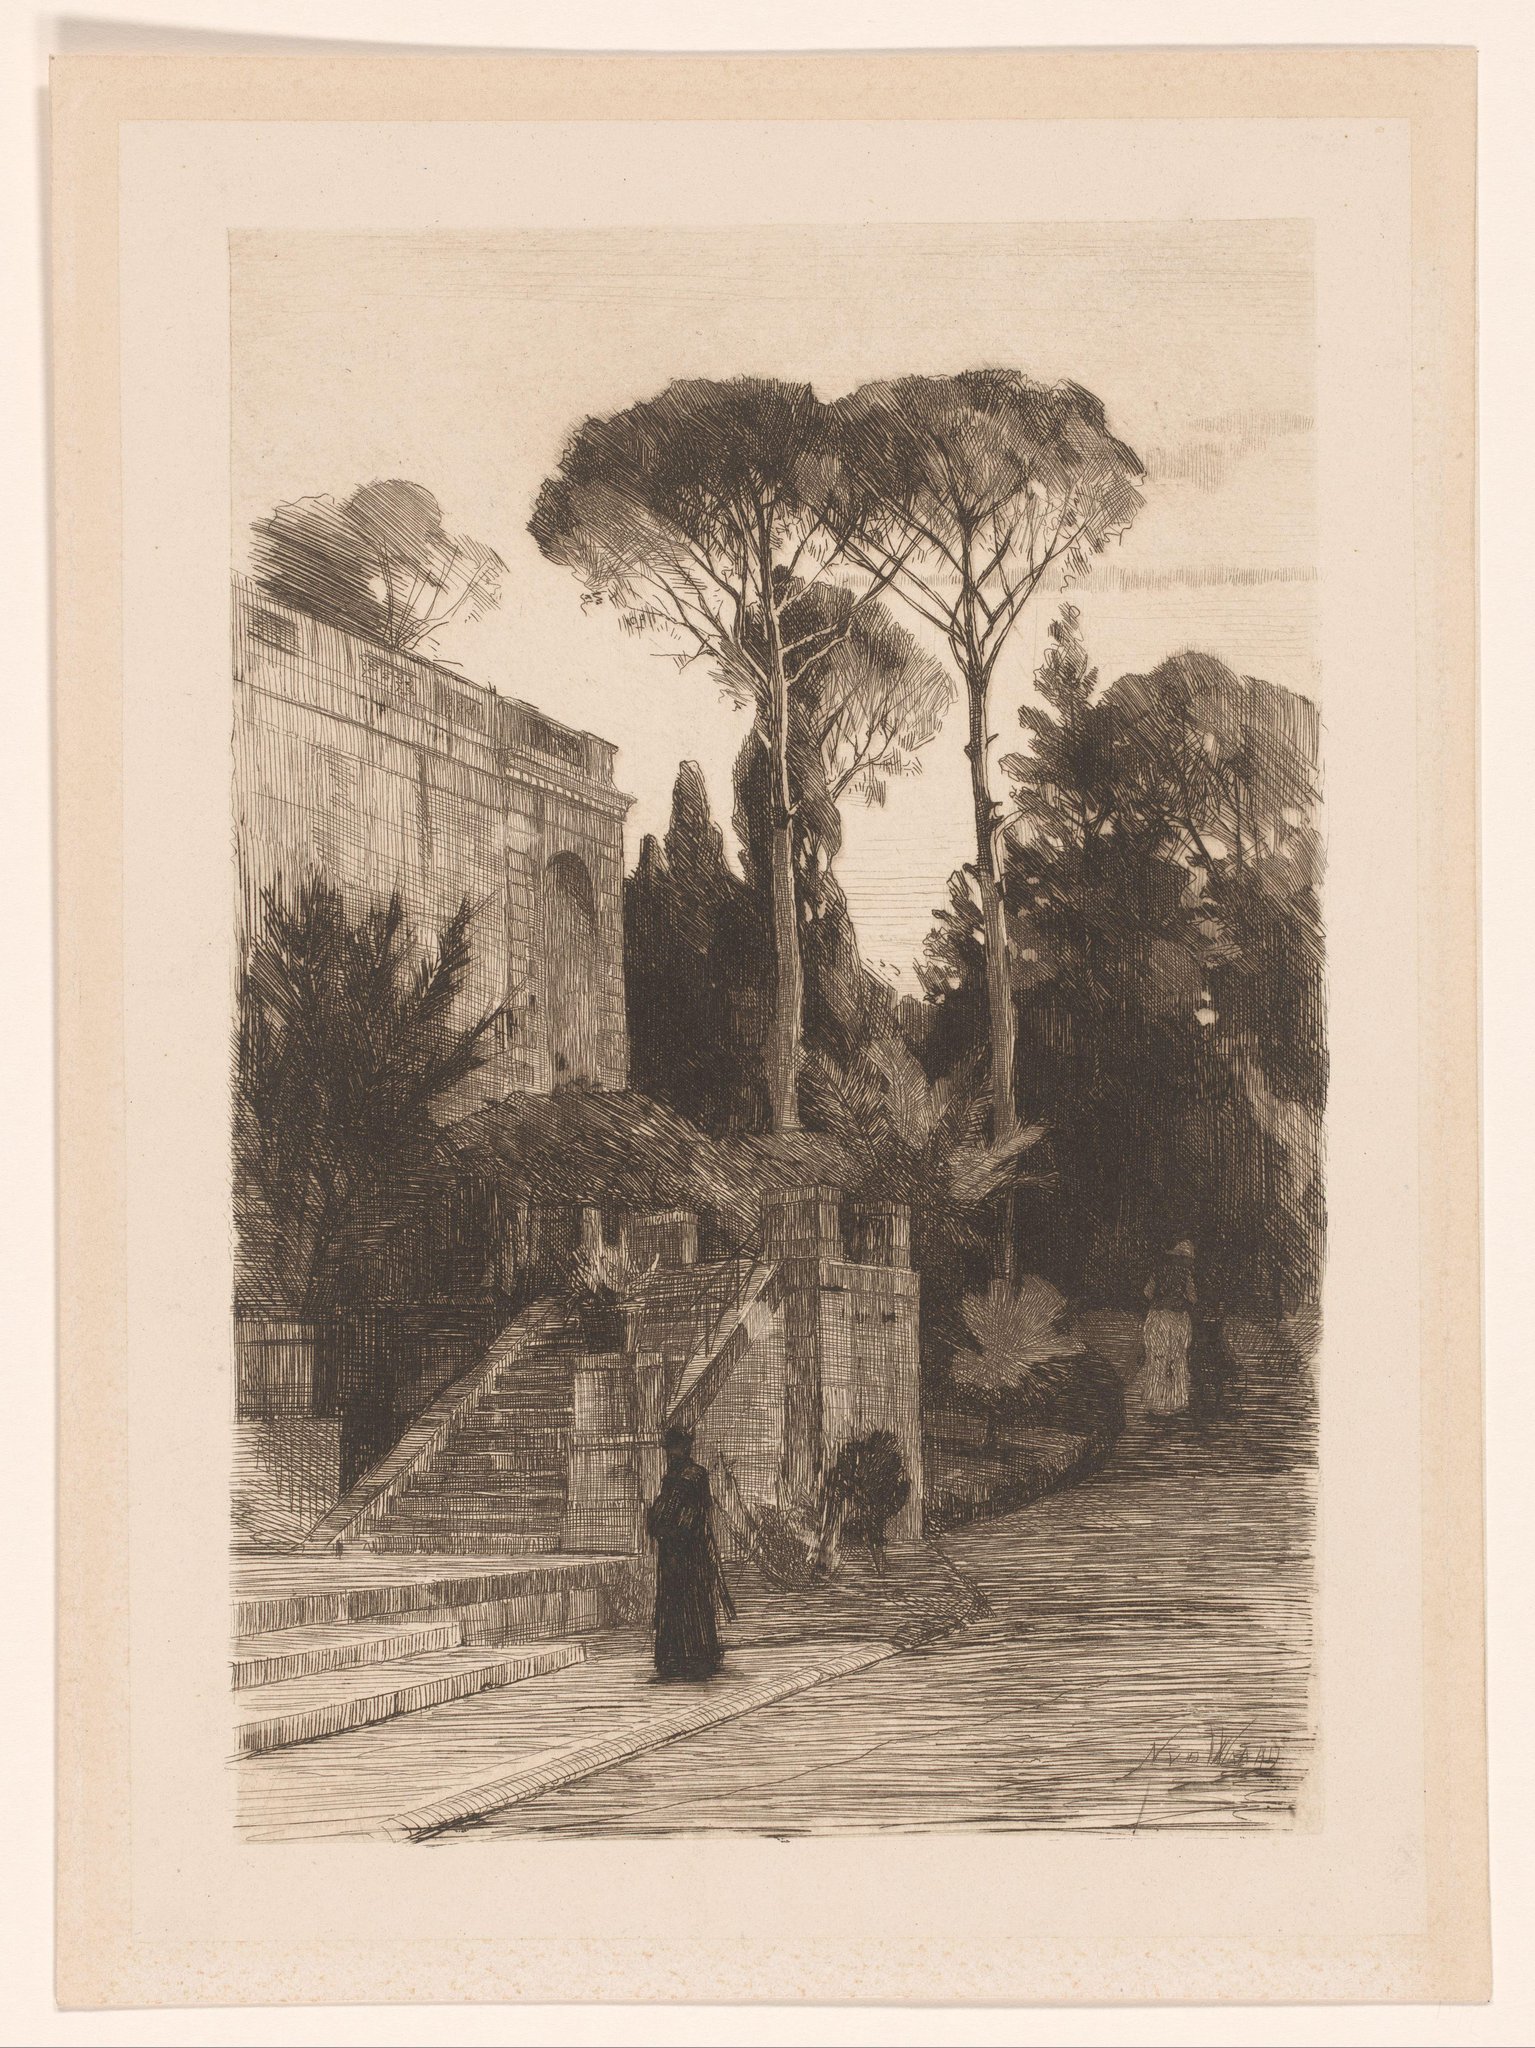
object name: print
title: Monumentaal gebouw met tuin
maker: nicolaas van der waay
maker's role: draughtsman, painter, print maker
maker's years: 1855-1936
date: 1865-1895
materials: paper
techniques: drypoint, etching, intaglio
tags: trees, garden, civic architecture; edifices; dwellings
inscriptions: collector's mark: Lugt 2760, collector's mark: Lugt 2228